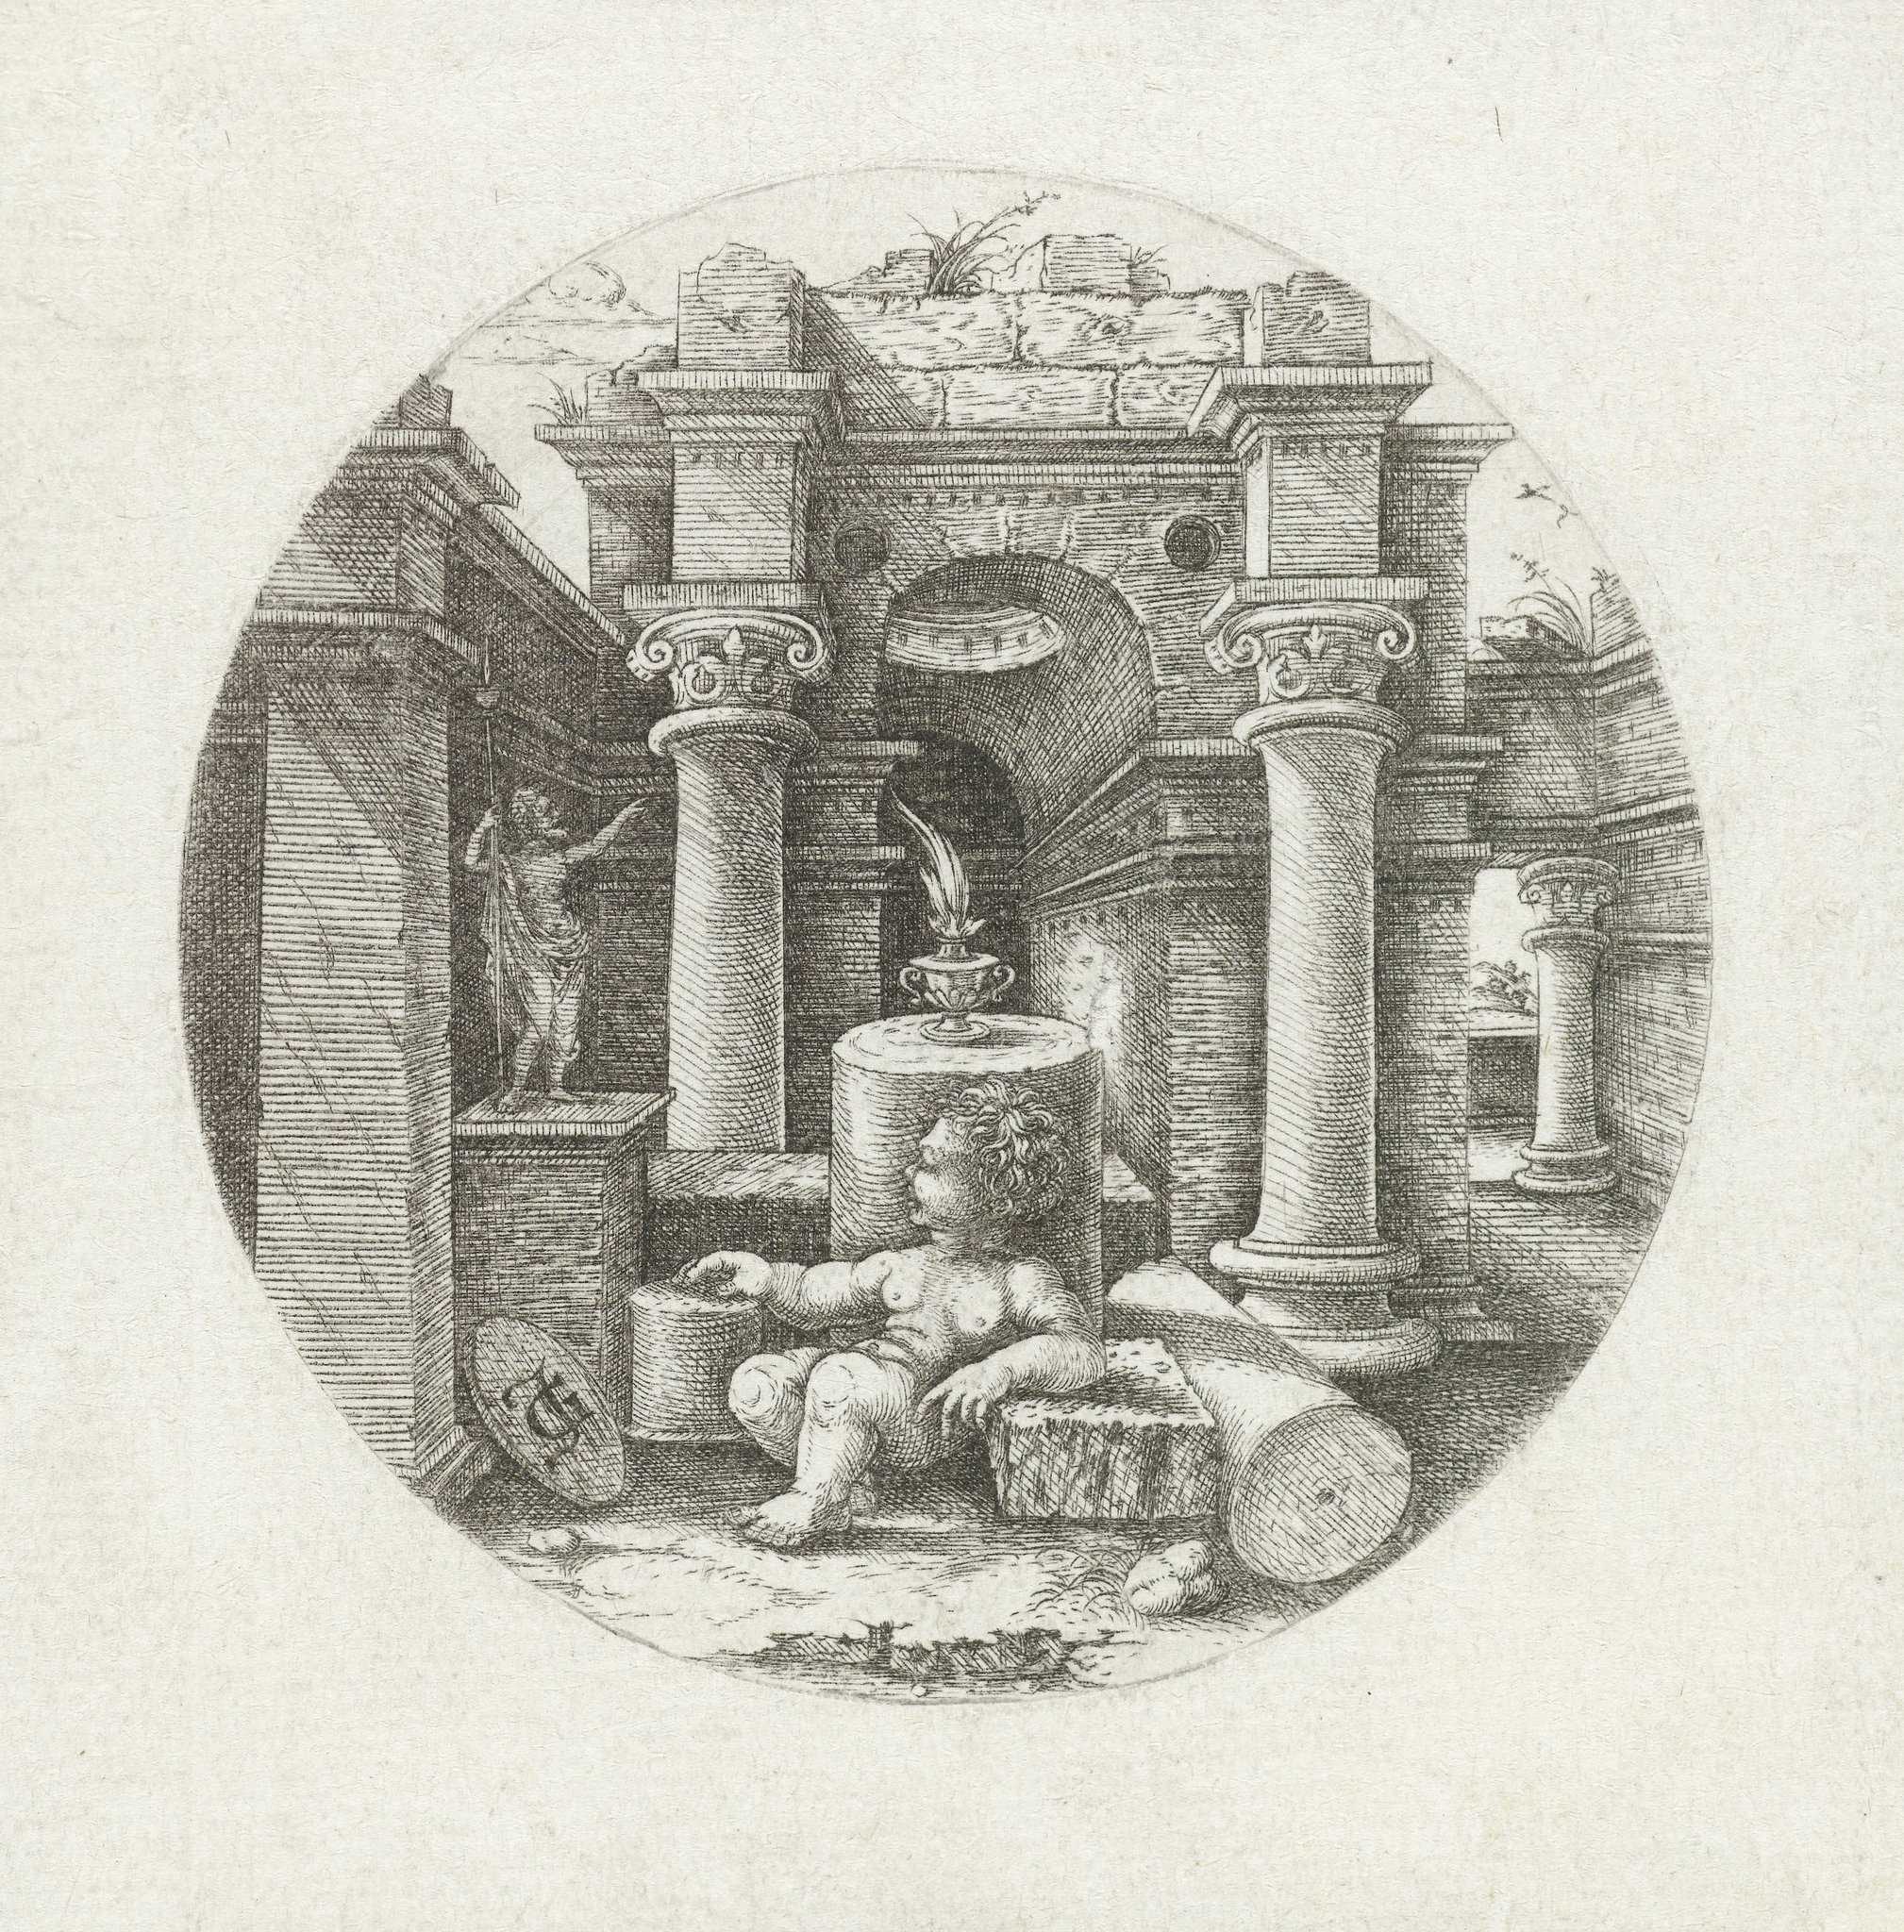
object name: print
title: Zittend kind temidden van ruïne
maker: jean de gourmont (i)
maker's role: goldsmith, painter, print maker, publisher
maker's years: 1483-1557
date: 1498-1551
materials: paper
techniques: engraving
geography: france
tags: ruin of a building ~ architecture, child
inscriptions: collector's mark: Lugt 2760, collector's mark: Lugt 2228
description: Een naakt kind, zittend tussen de brokstukken van een zuil, in een ruïne van een gebouw.